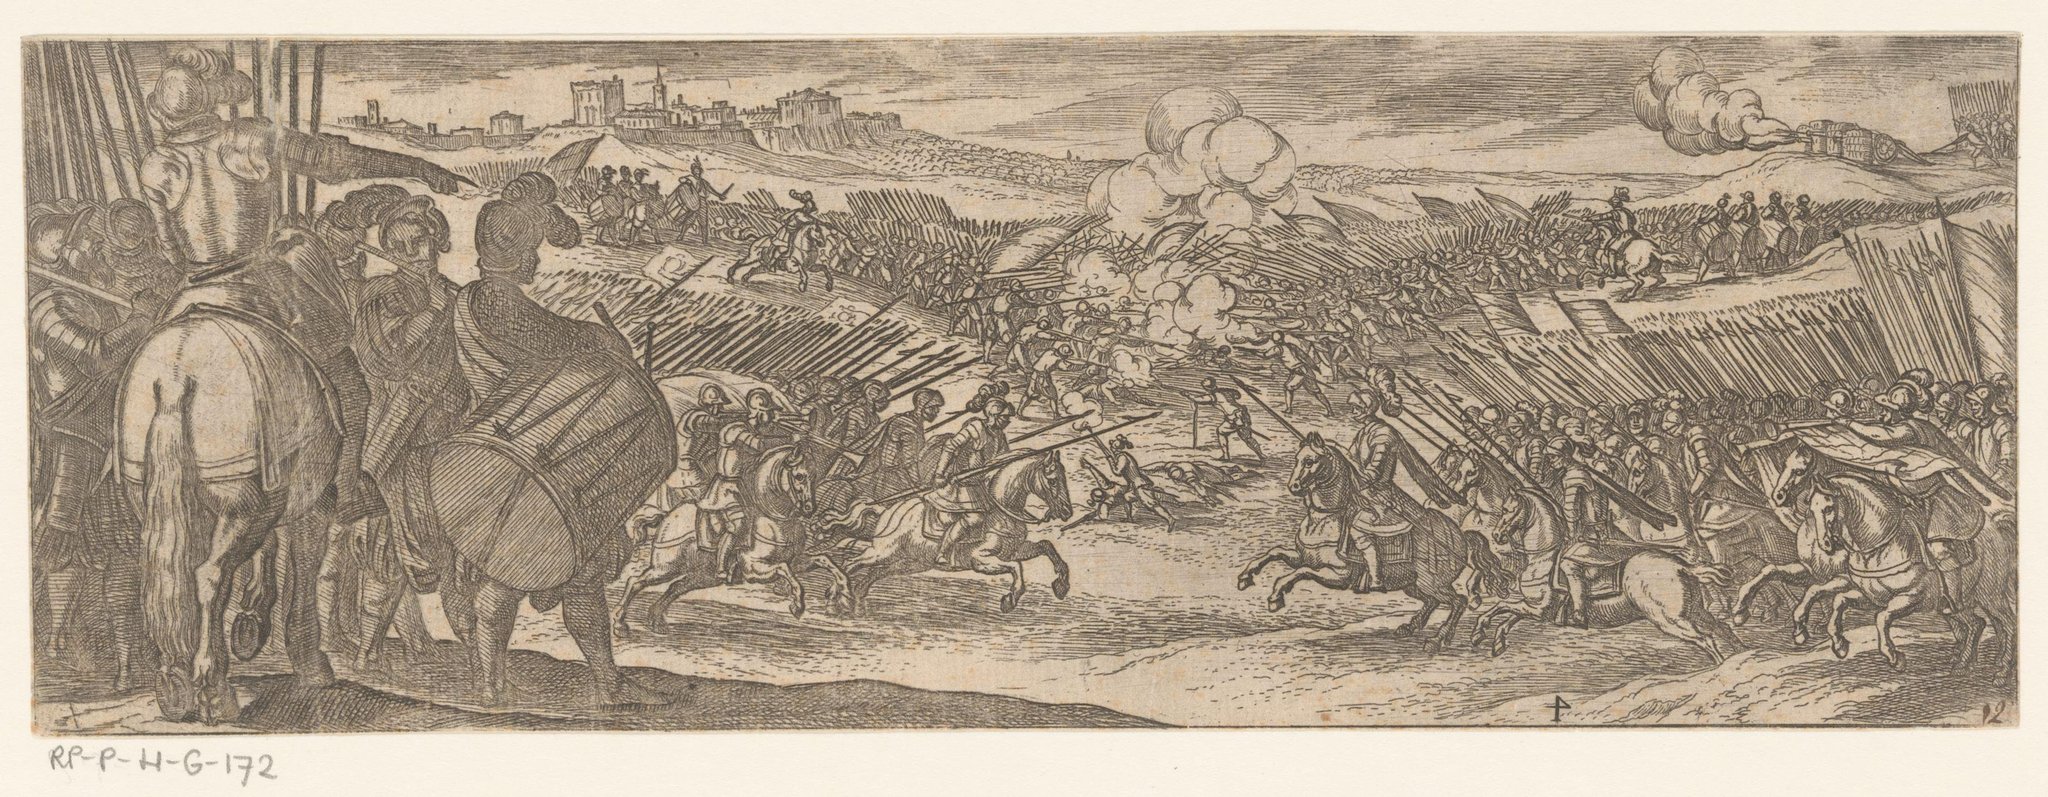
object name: print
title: Twee legers elkaar aanvallend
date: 1599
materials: paper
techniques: etching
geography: italy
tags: battle, warfare; military affairs (+ cavalry, horsemen), the soldier; the soldier's life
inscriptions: collector's mark: ‘Hinloopen’, number: ‘12’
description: Deze prent maakt deel uit van een reeks van 9 prenten (+ titelprent) met gevechtsscènes. Antonio Tempesta maakte ook een eerdere serie met gevechtsscènes van 10 prenten (+titelprent).